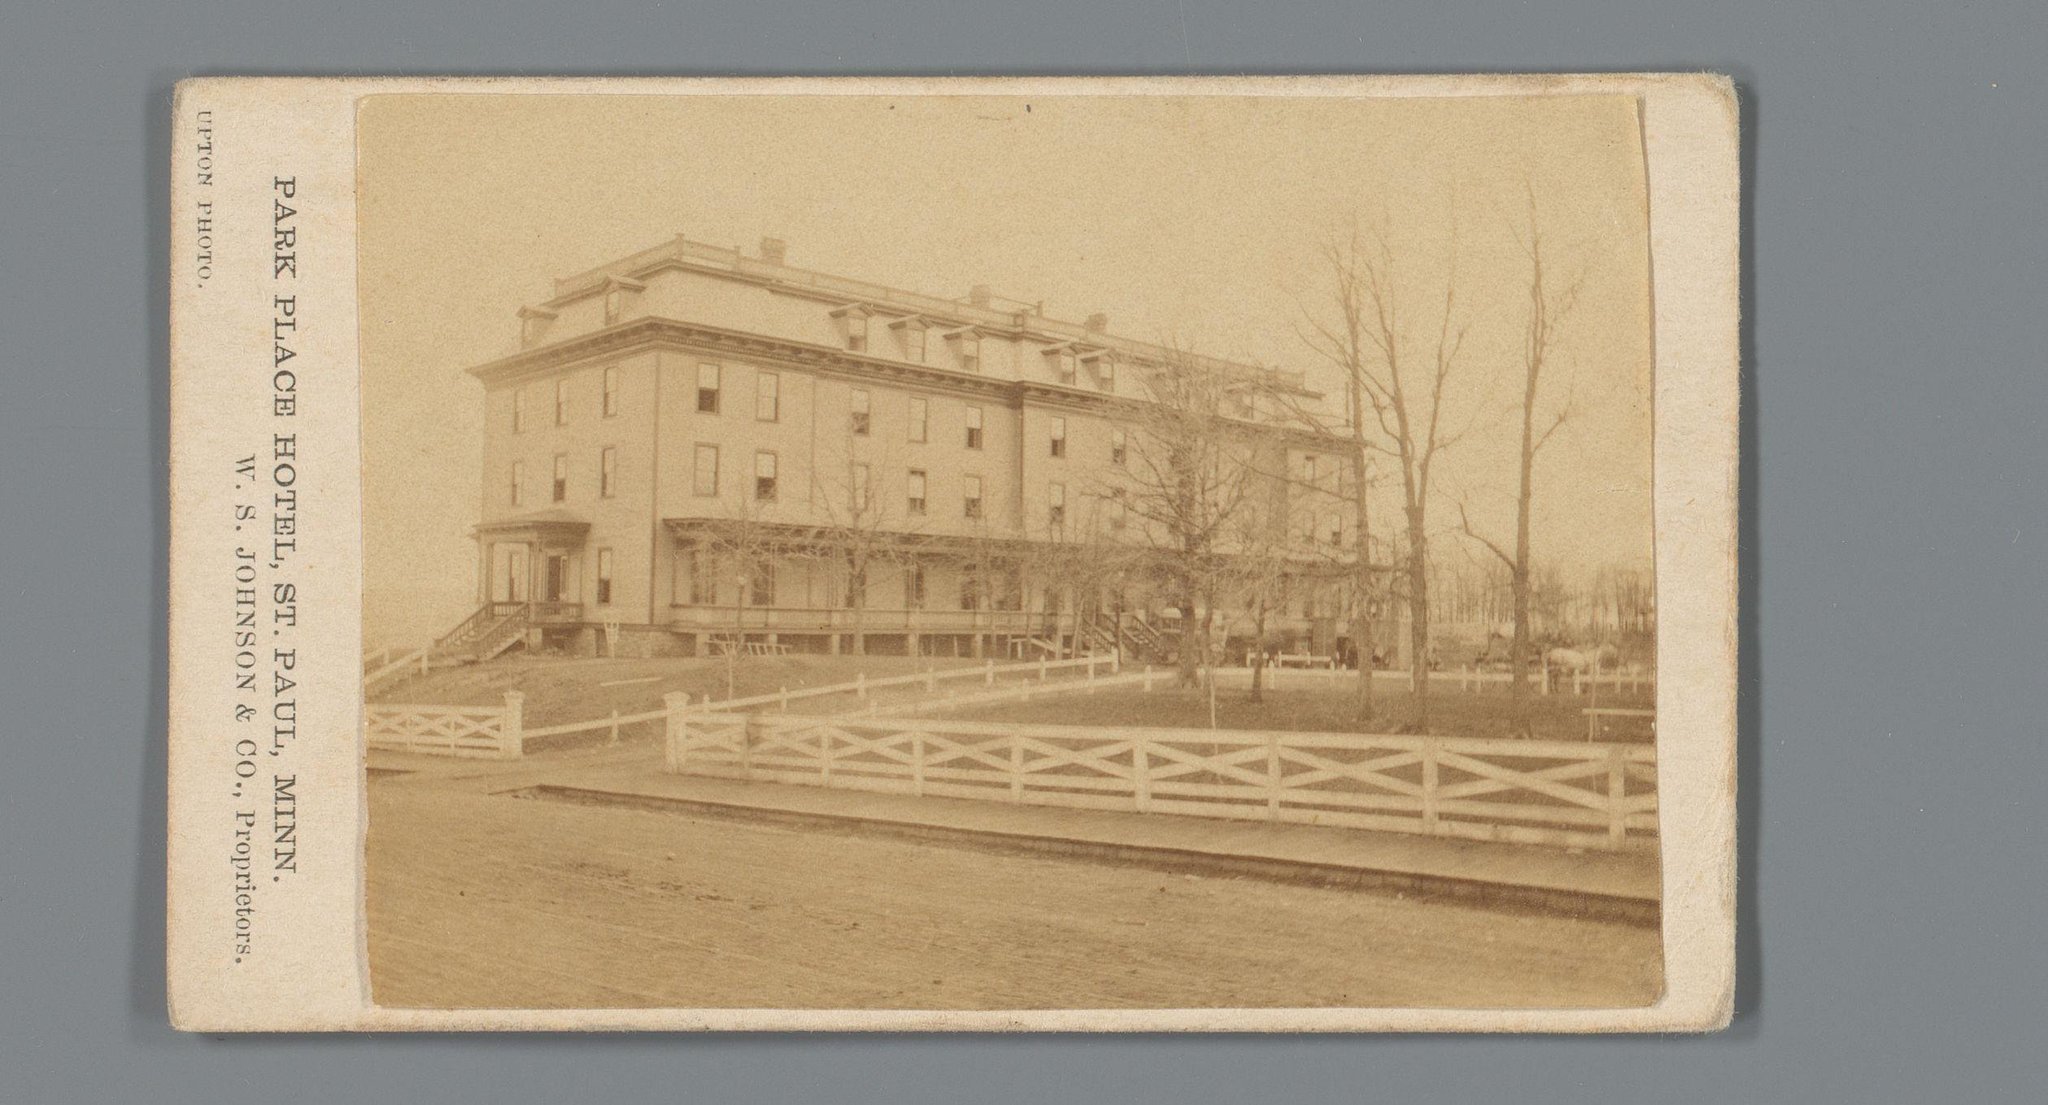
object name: carte de visite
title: Gezicht op voormalig Park Place Hotel in Saint Paul, Minnesota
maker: benjamin franklin upton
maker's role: fotograaf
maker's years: 1818-1901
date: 1850-1915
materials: cardboard, photographic support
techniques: albumen print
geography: united states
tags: advertising, hotel, hostelry, inn